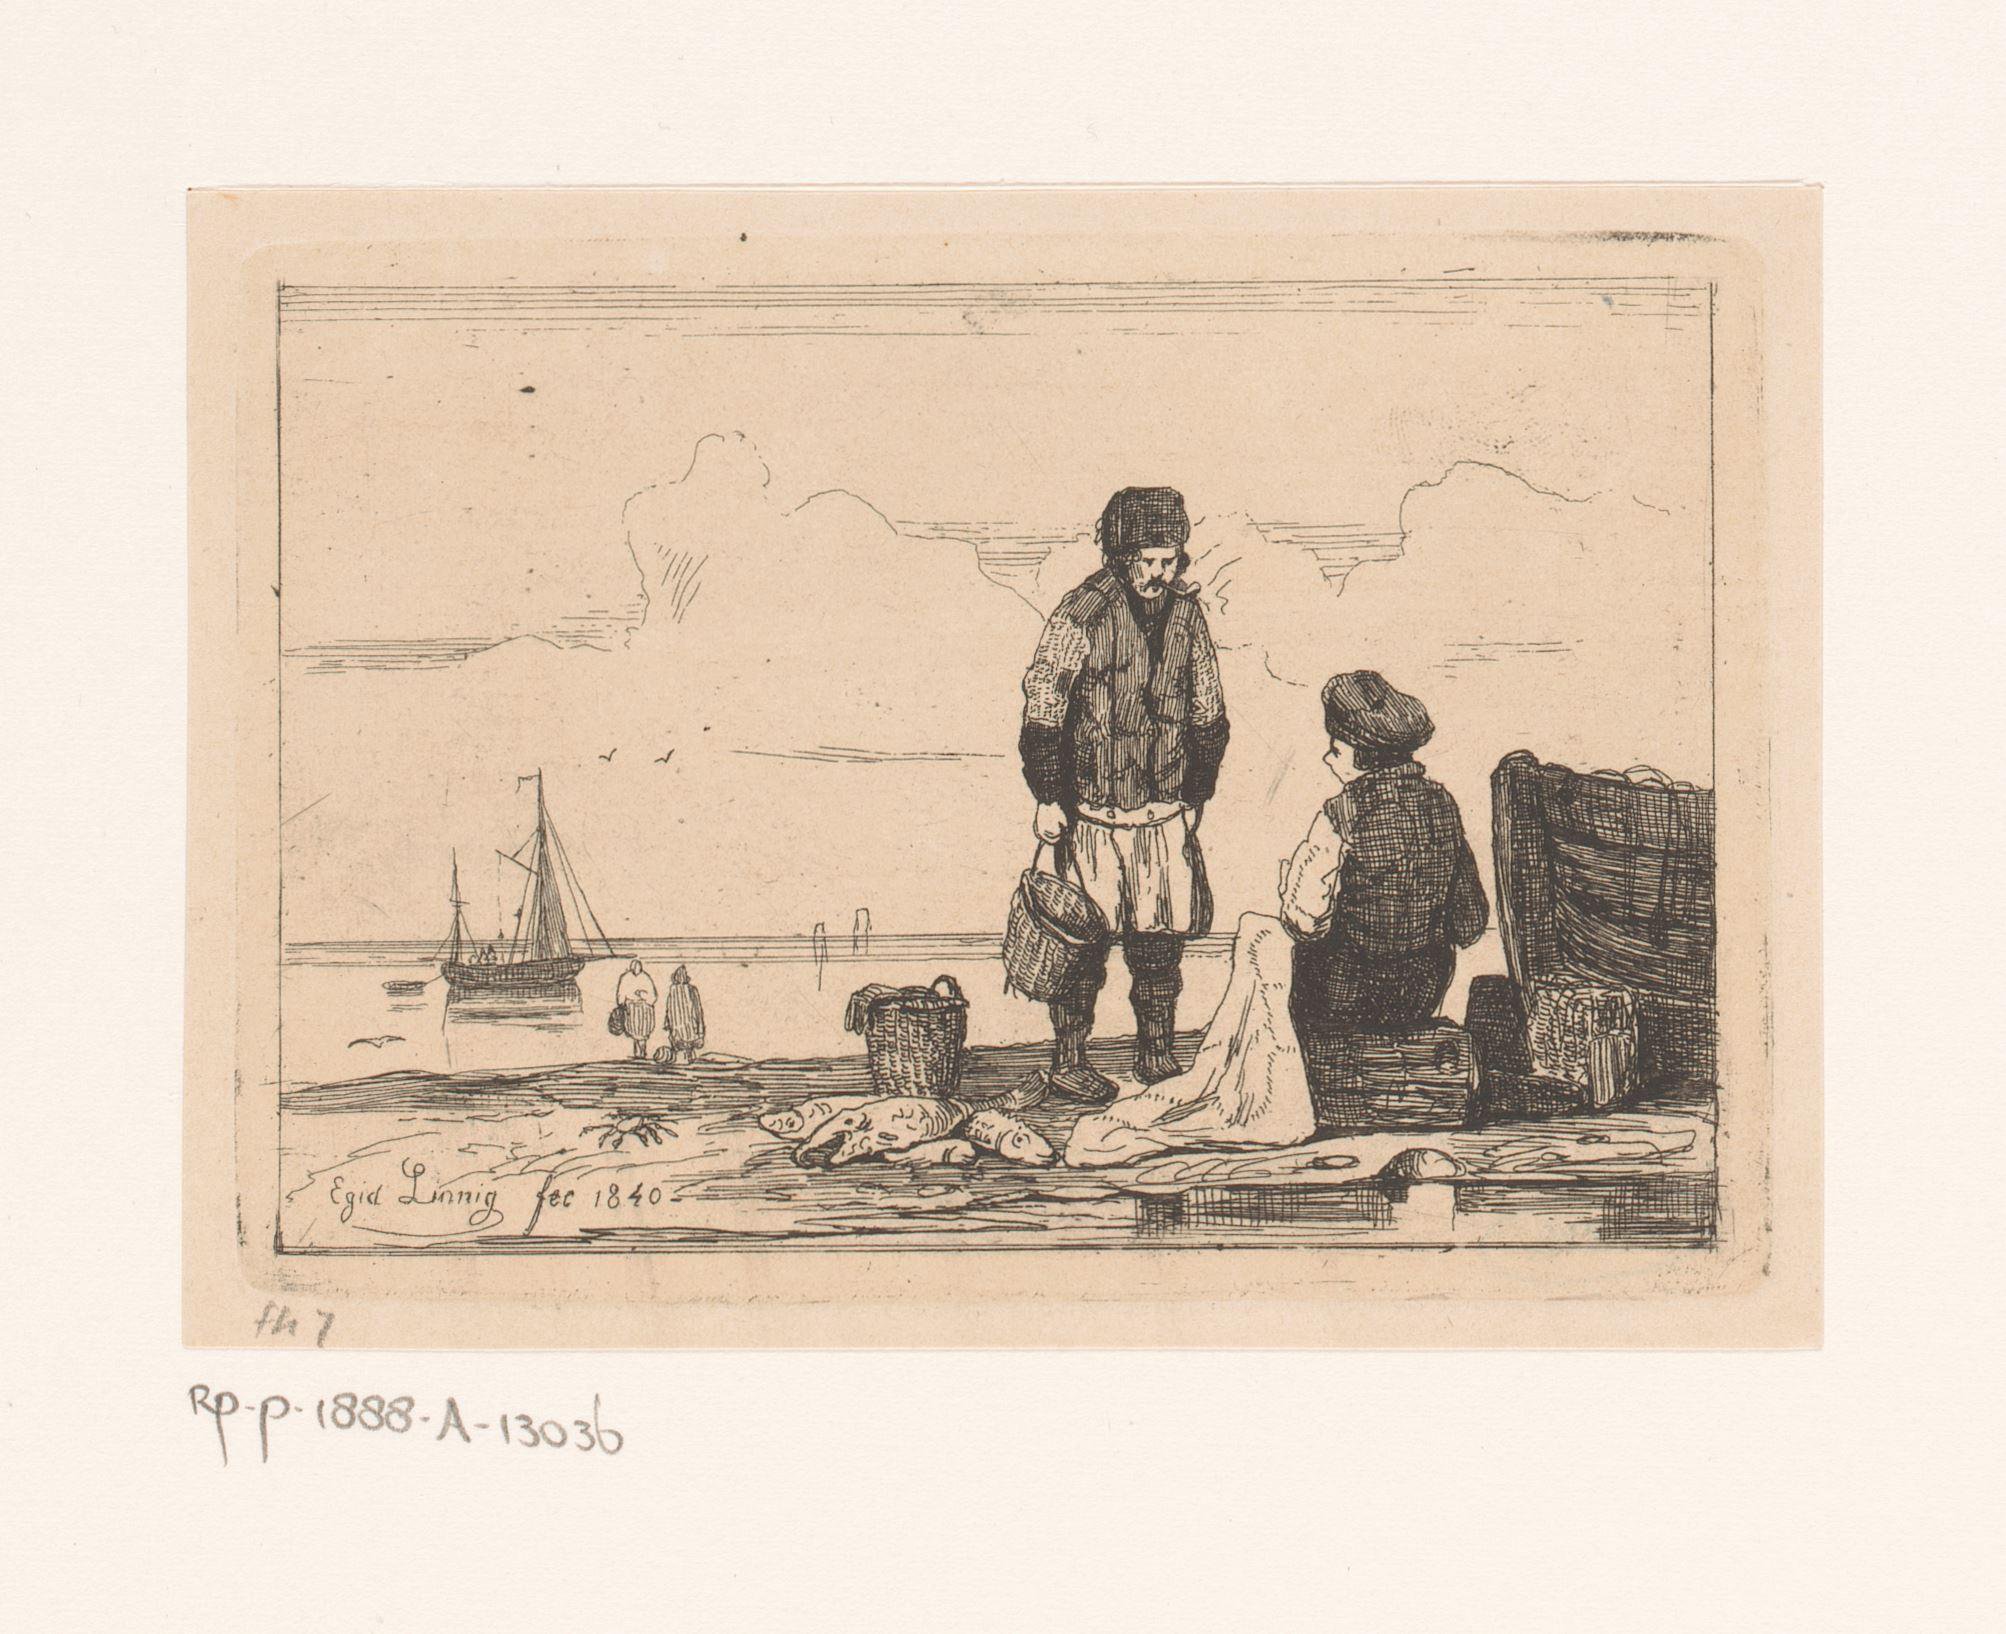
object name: print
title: Twee vissers aan het strand, de een repareert een zeil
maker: egidius linnig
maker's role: draughtsman, print maker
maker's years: 1821-1860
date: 1840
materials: paper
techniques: etching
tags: beach, fisherman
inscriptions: collector's mark: Lugt 2228